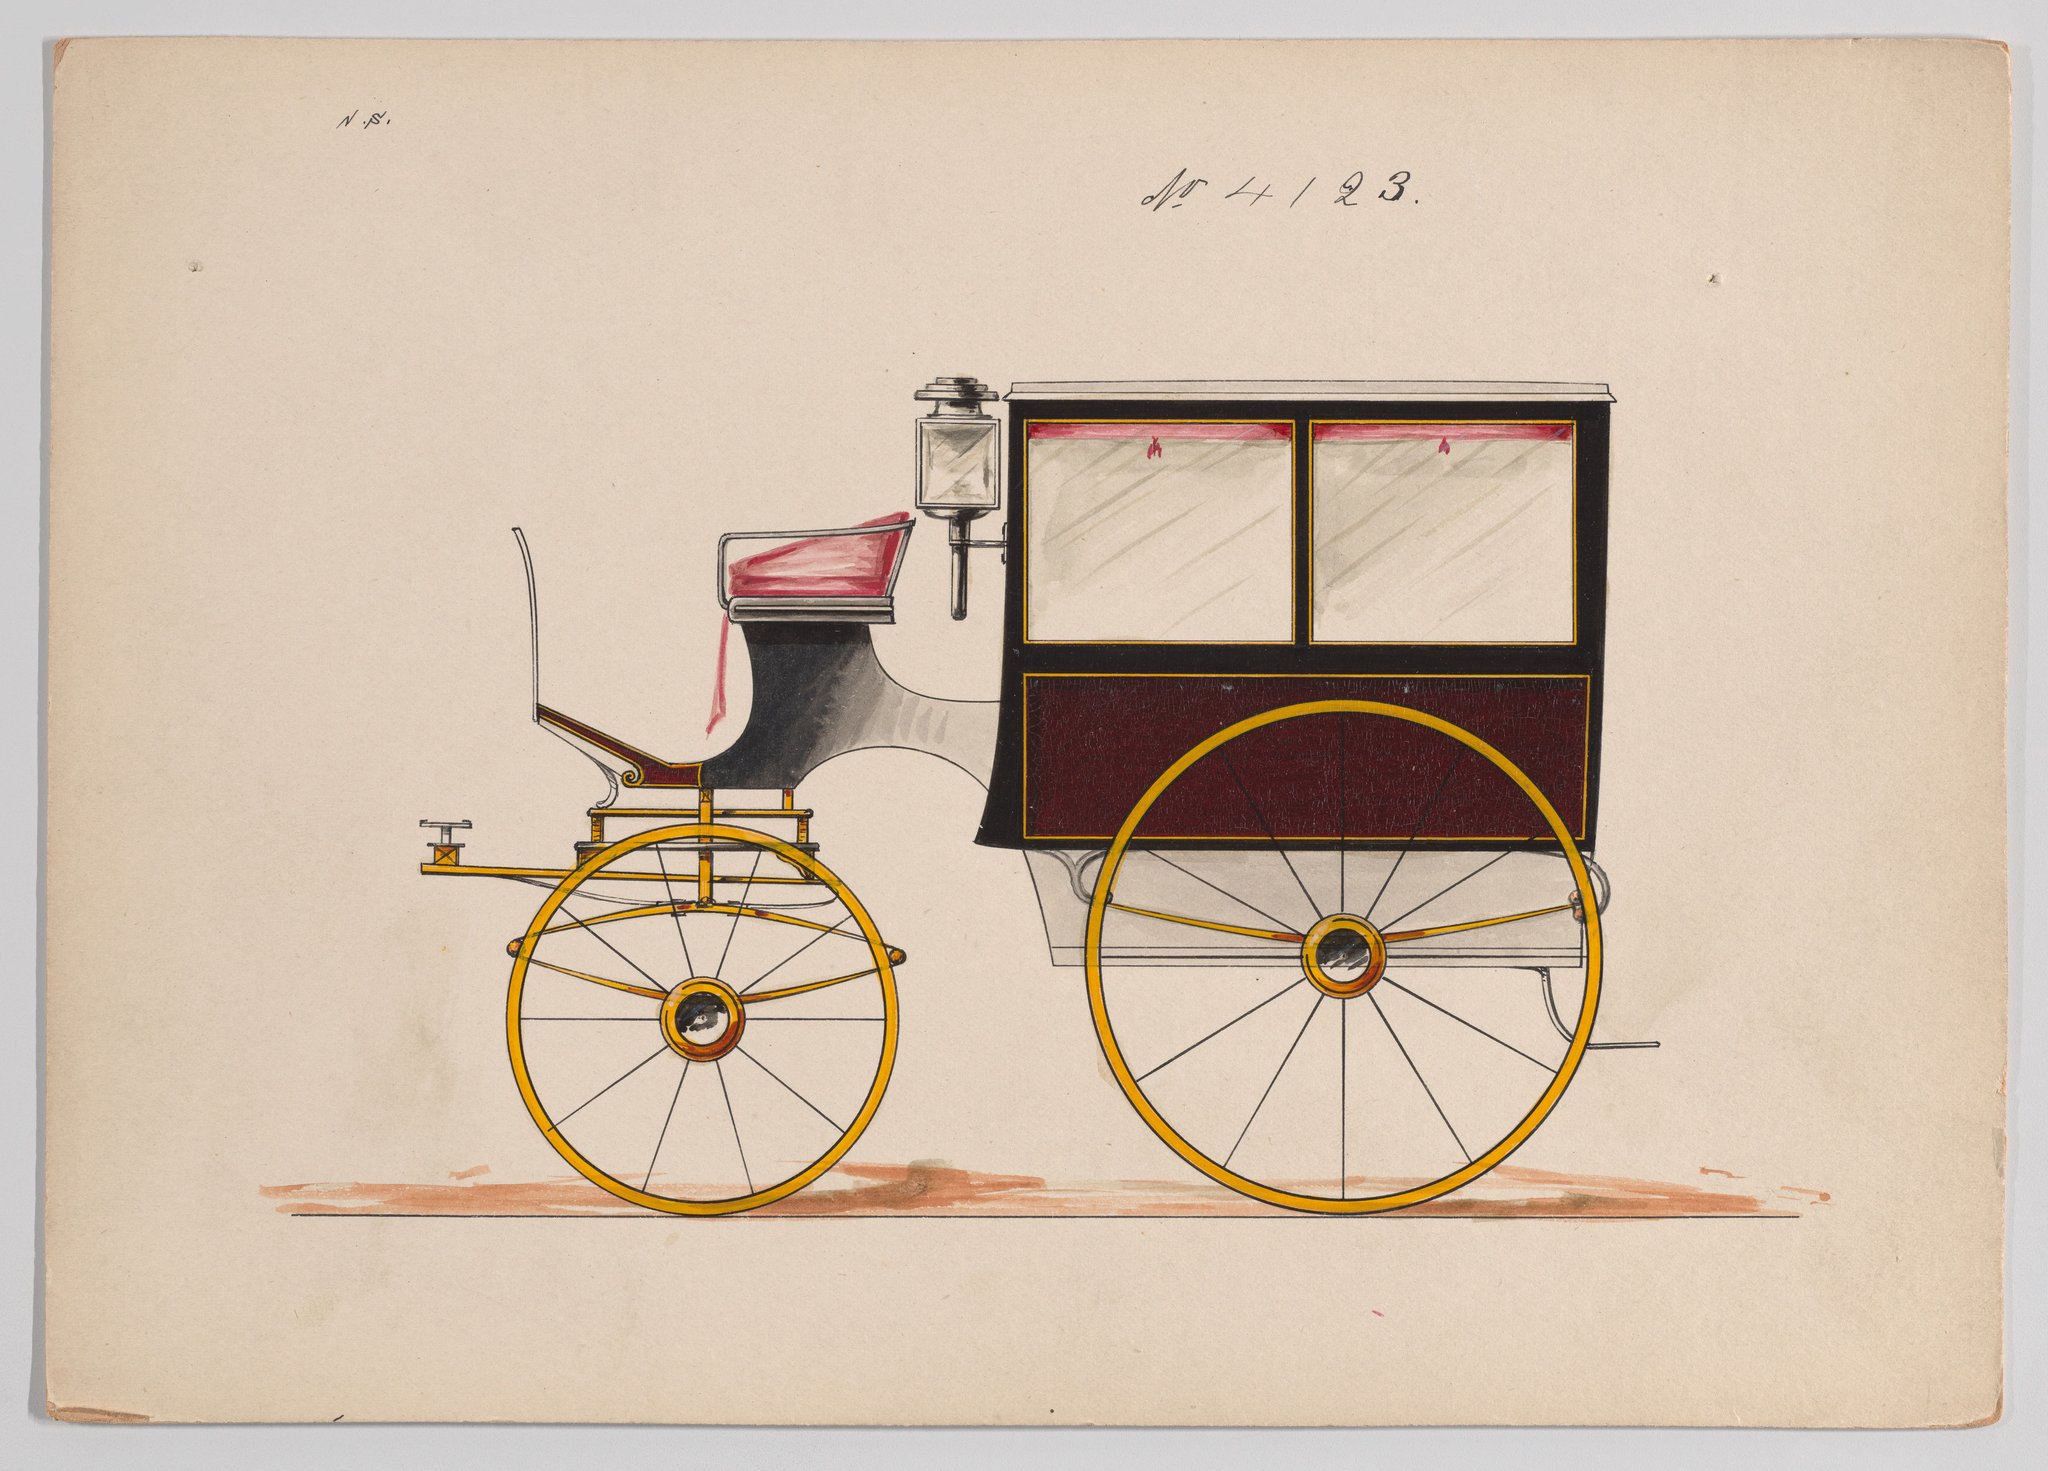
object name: drawing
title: Design for Omnibus or Wagonette, no. 4123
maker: brewster & co.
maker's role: manufacturer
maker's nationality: american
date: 1891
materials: gouache, ink, watercolor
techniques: pen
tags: carriages